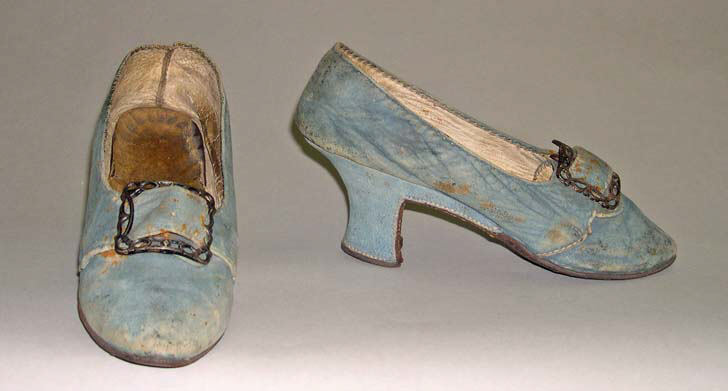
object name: shoe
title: Shoes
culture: european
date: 1767-1800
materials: leather, metal